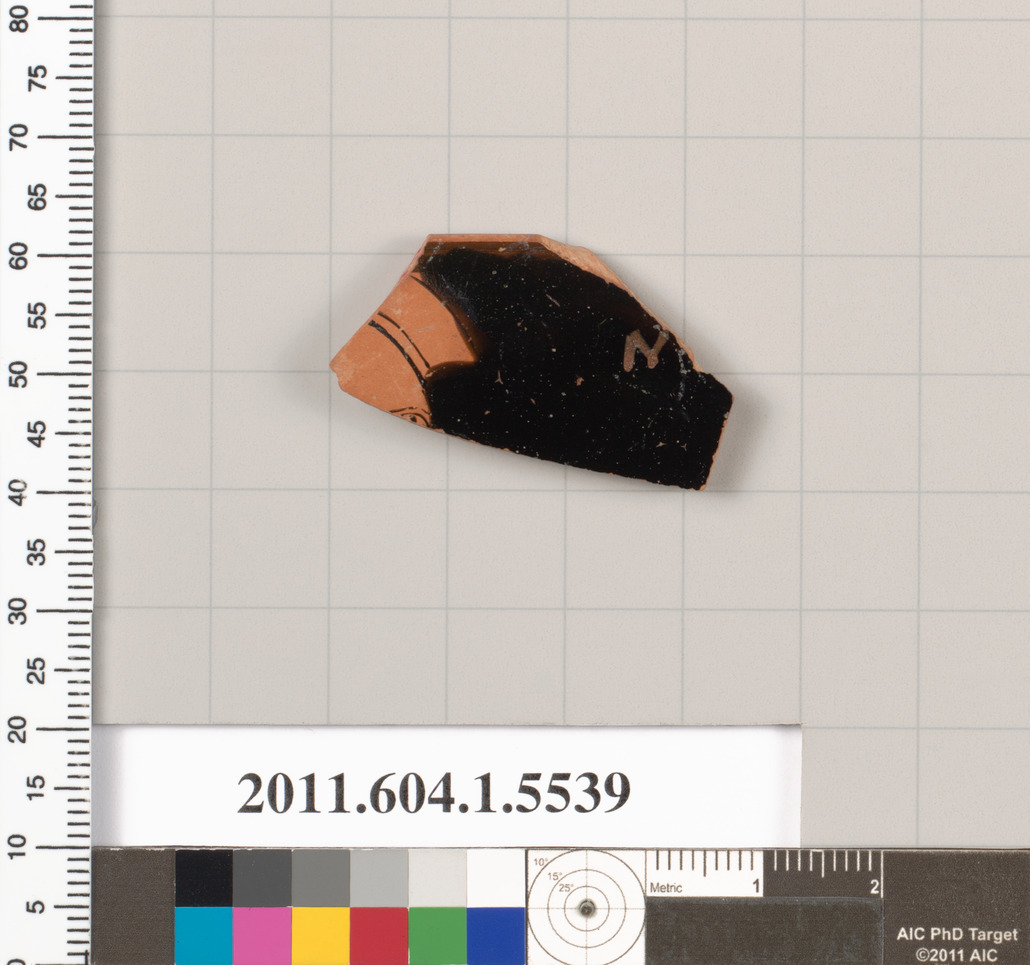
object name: kylix fragment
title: Terracotta rim fragment of a kylix (drinking cup)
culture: greek, attic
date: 520-500 BCE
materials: terracotta